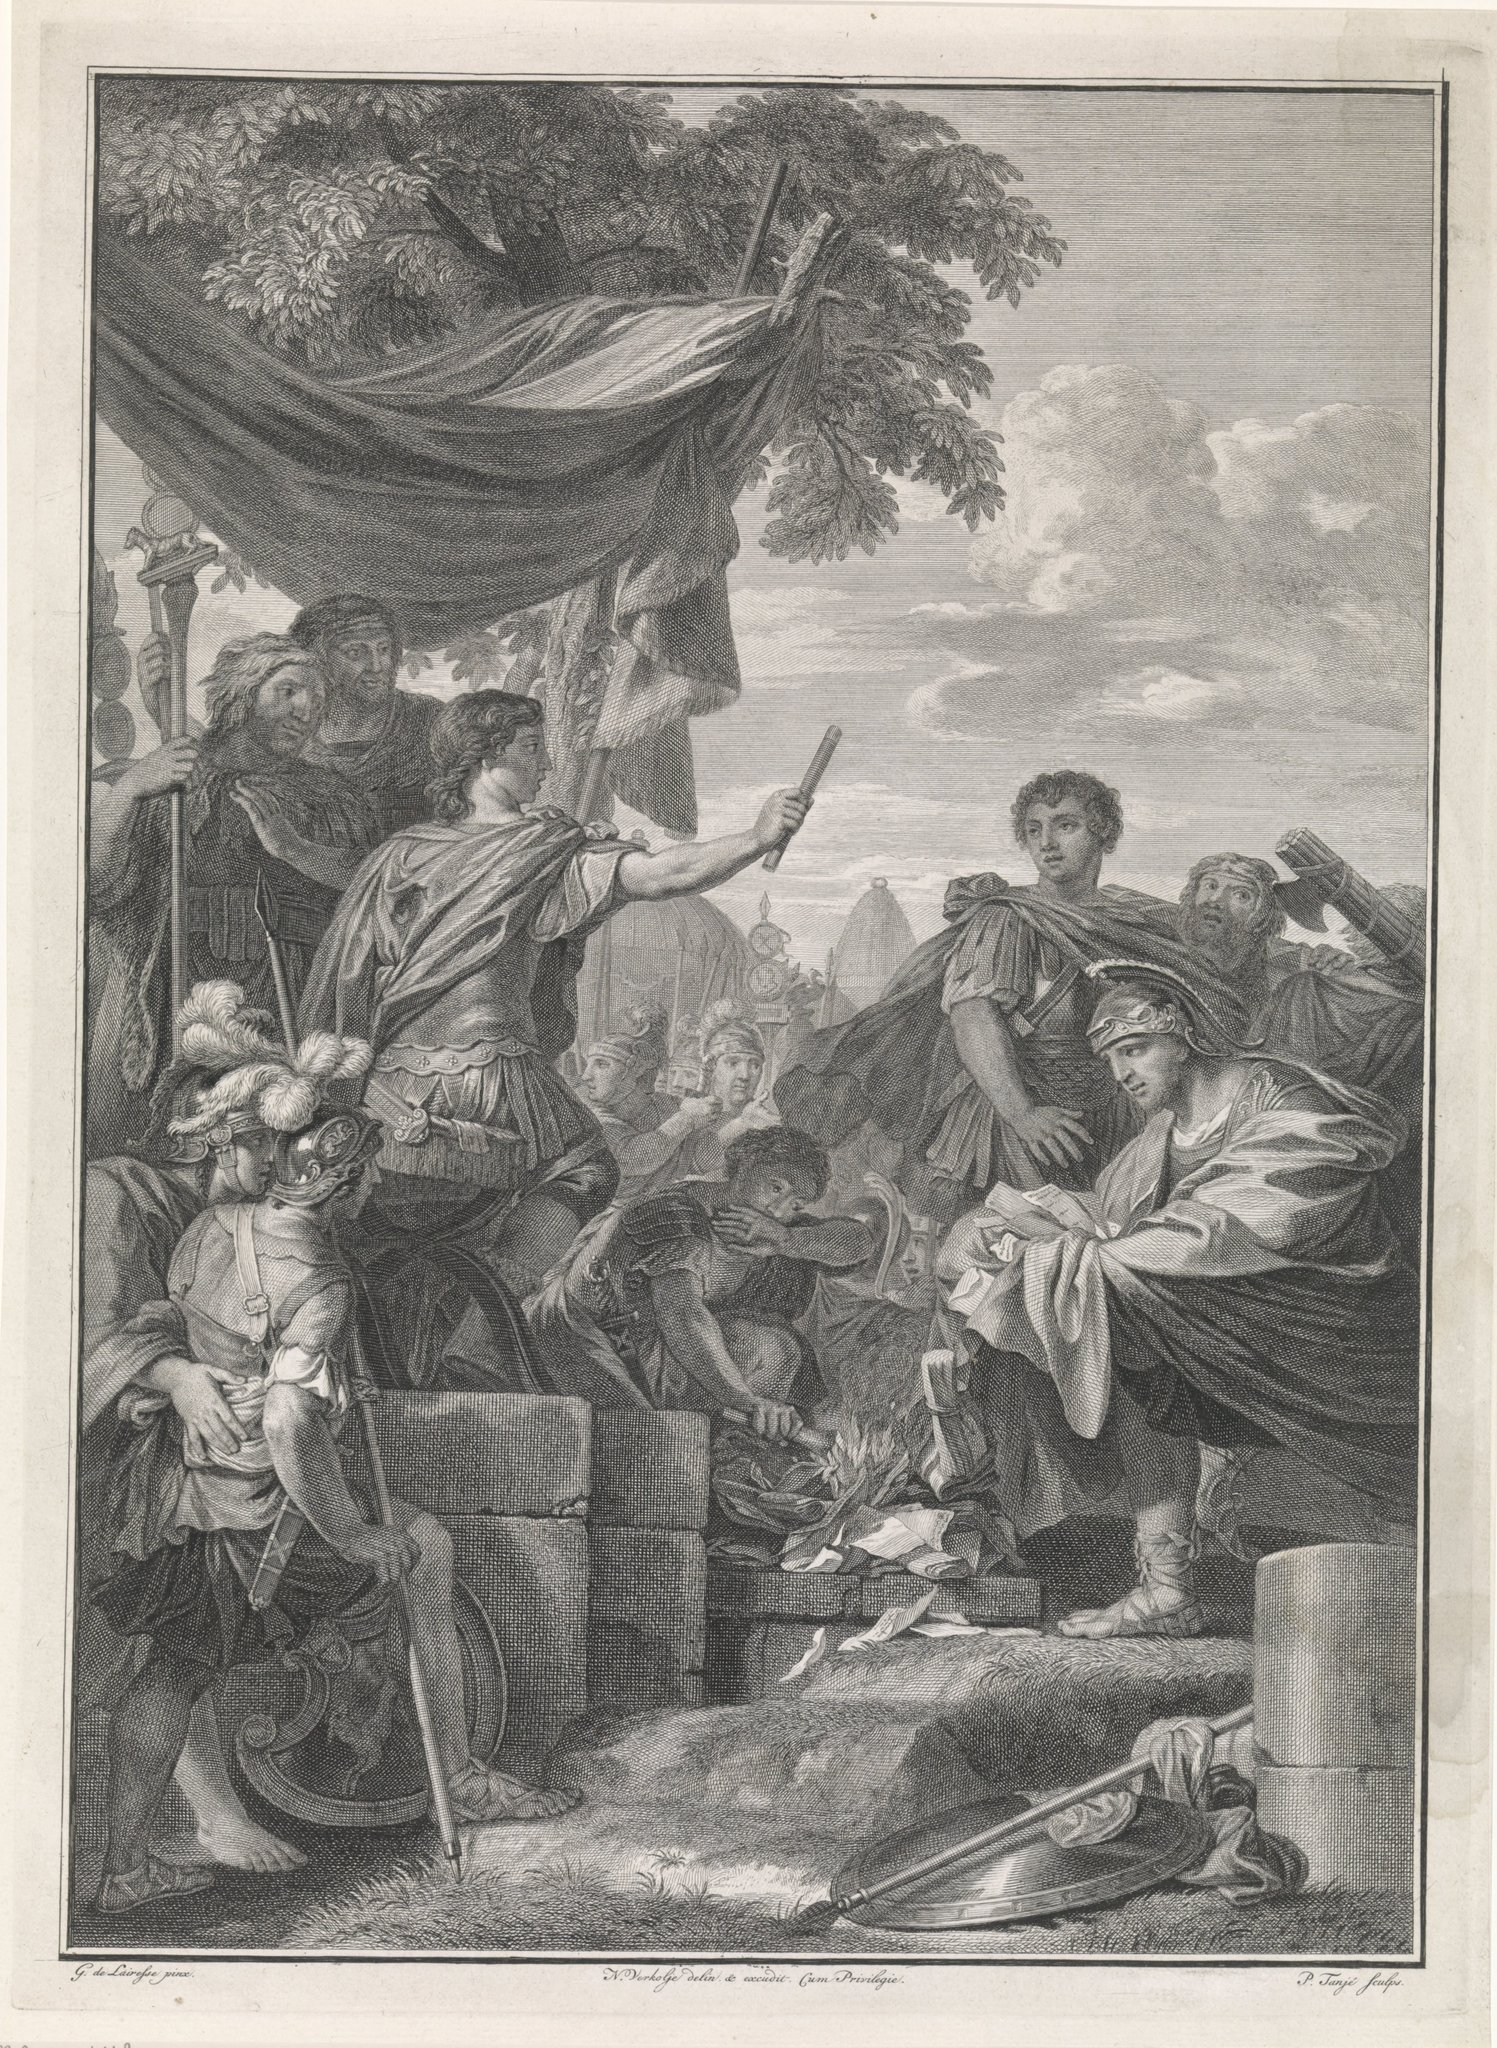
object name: print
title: Pompeius laat de brieven van Marcus Peperna verbranden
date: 1737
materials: paper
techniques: engraving, etching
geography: amsterdam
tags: (story of) sextus pompeius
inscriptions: collector's mark: Lugt 2228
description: Sextus Pompeius, met bevelhebberstaf in de hand, laat de brieven van Marcus Peperna verbranden. Naar het schilderij in de Raadkamer van het Hof van Justitie van Holland, Zeeland en West-Friesland op het Binnenhof te Den Haag.